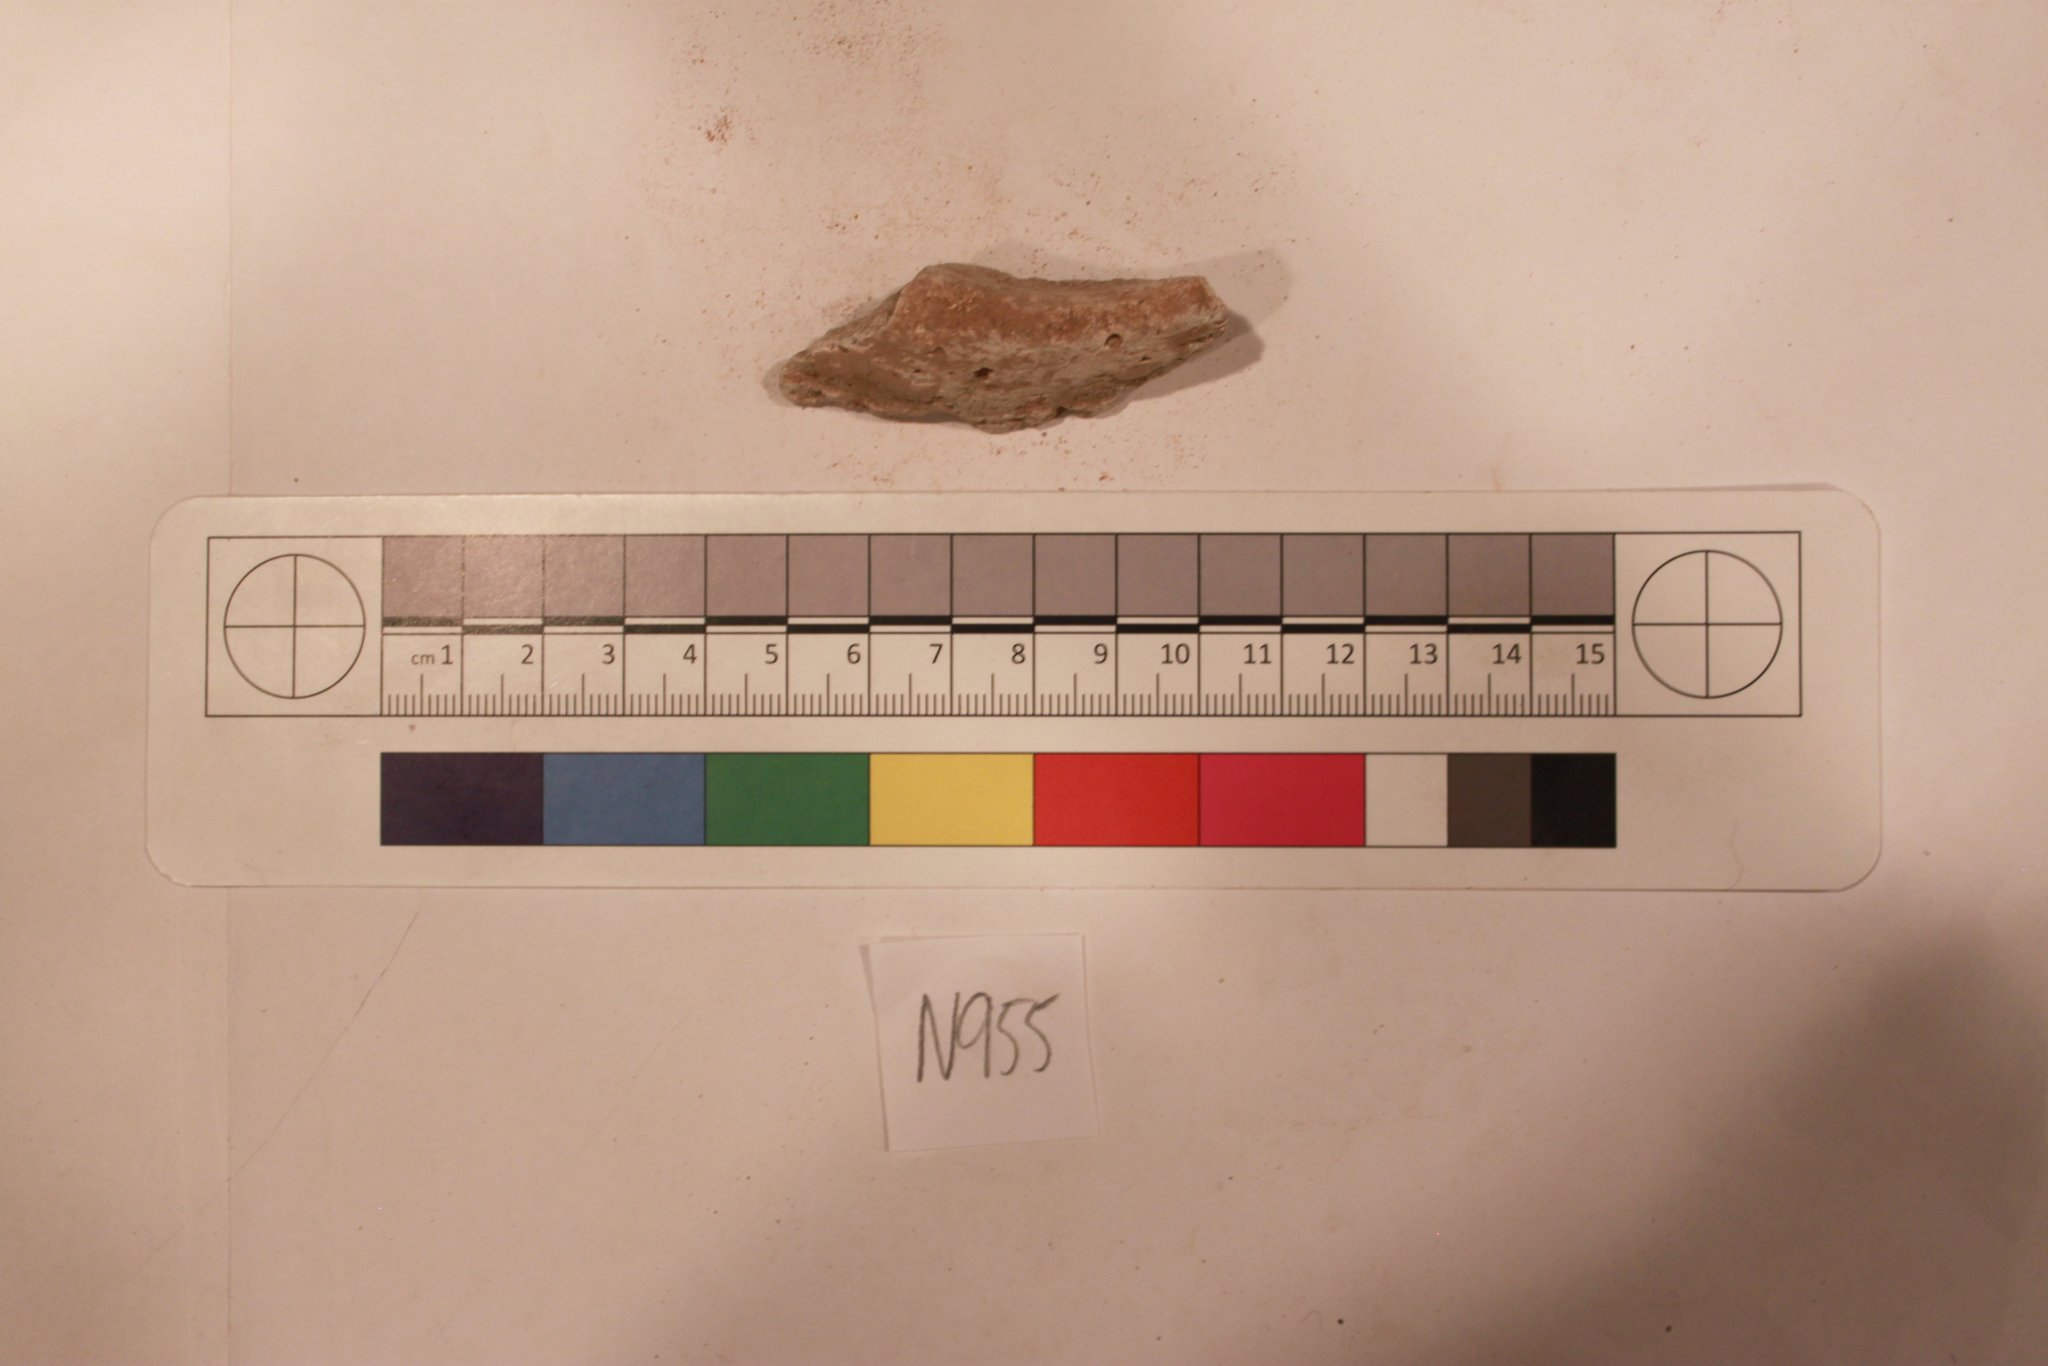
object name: fragment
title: Stucco Fragment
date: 701-1200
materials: plaster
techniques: carving, painting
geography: iran